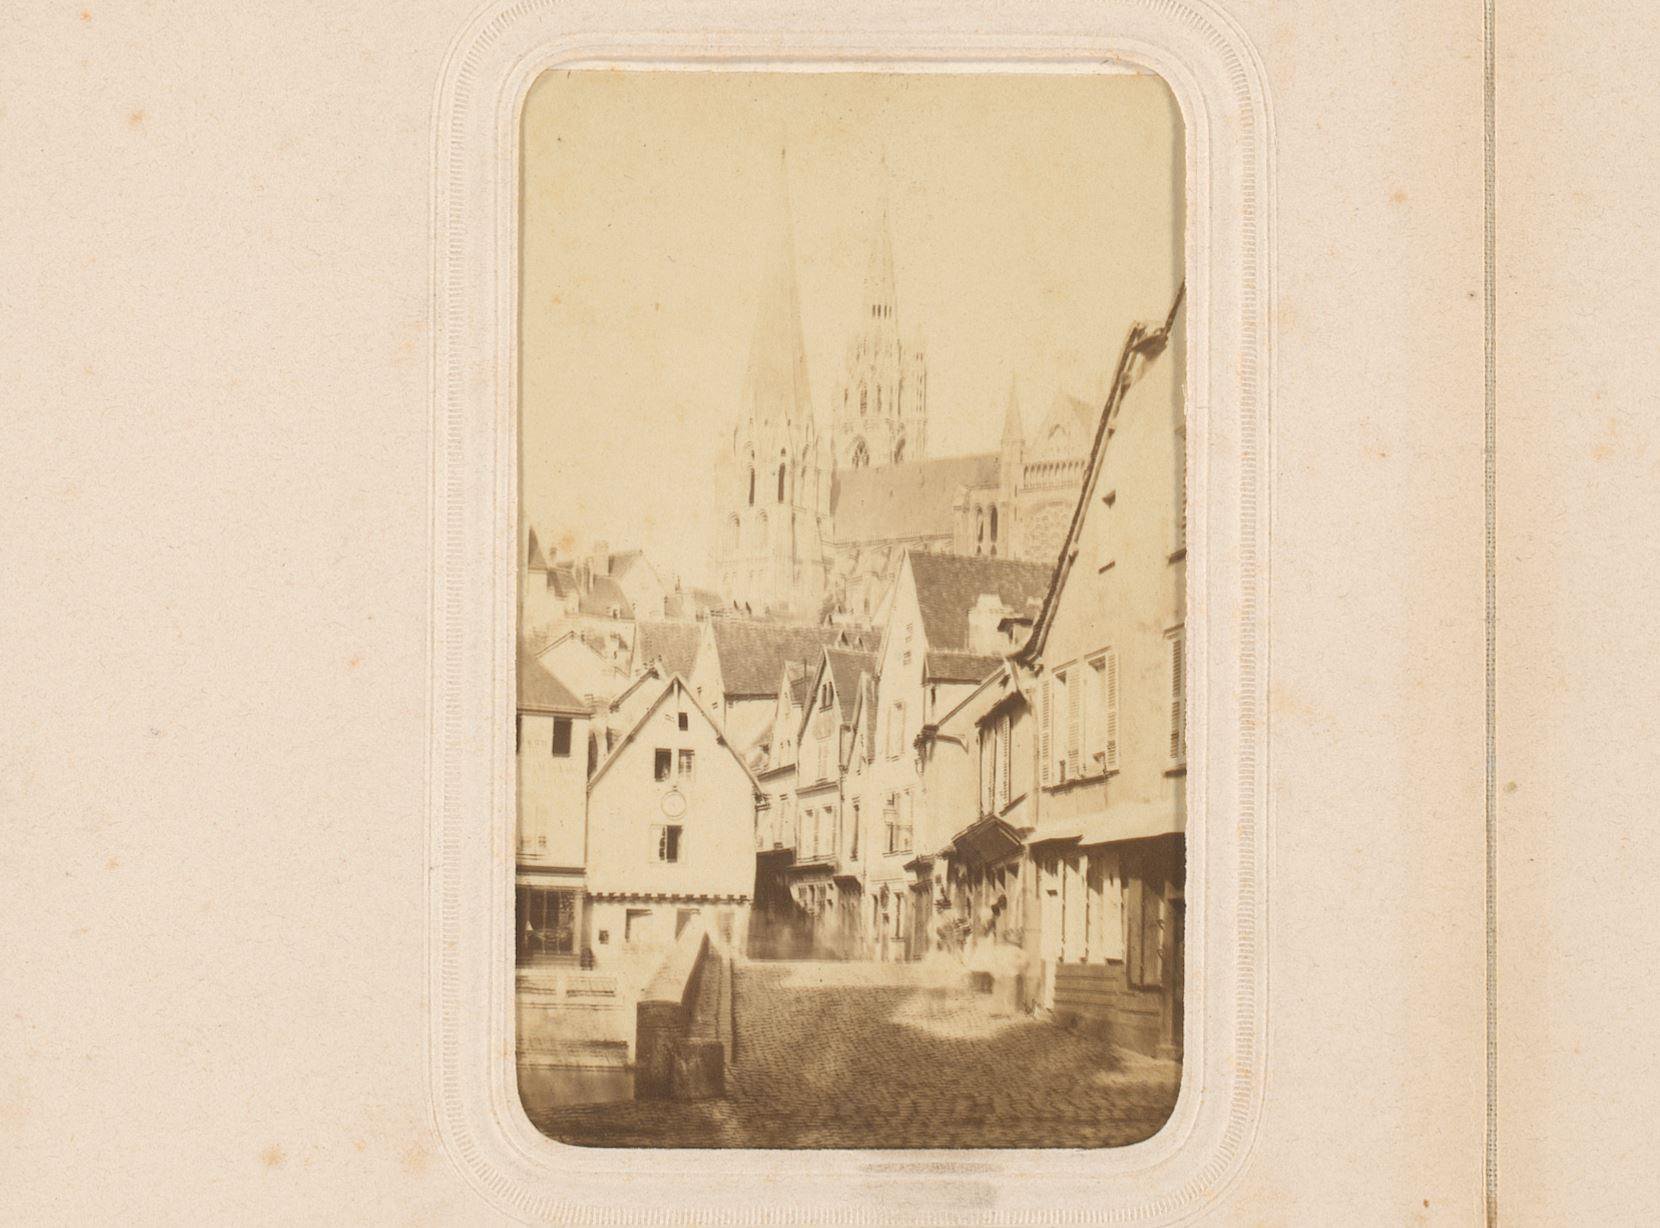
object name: album leaf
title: Stadsgezicht met op de achtergrond een kerk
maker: Anonymous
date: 1860-1900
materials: cardboard, photographic support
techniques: albumen print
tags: city-view in general; 'veduta', church (exterior)